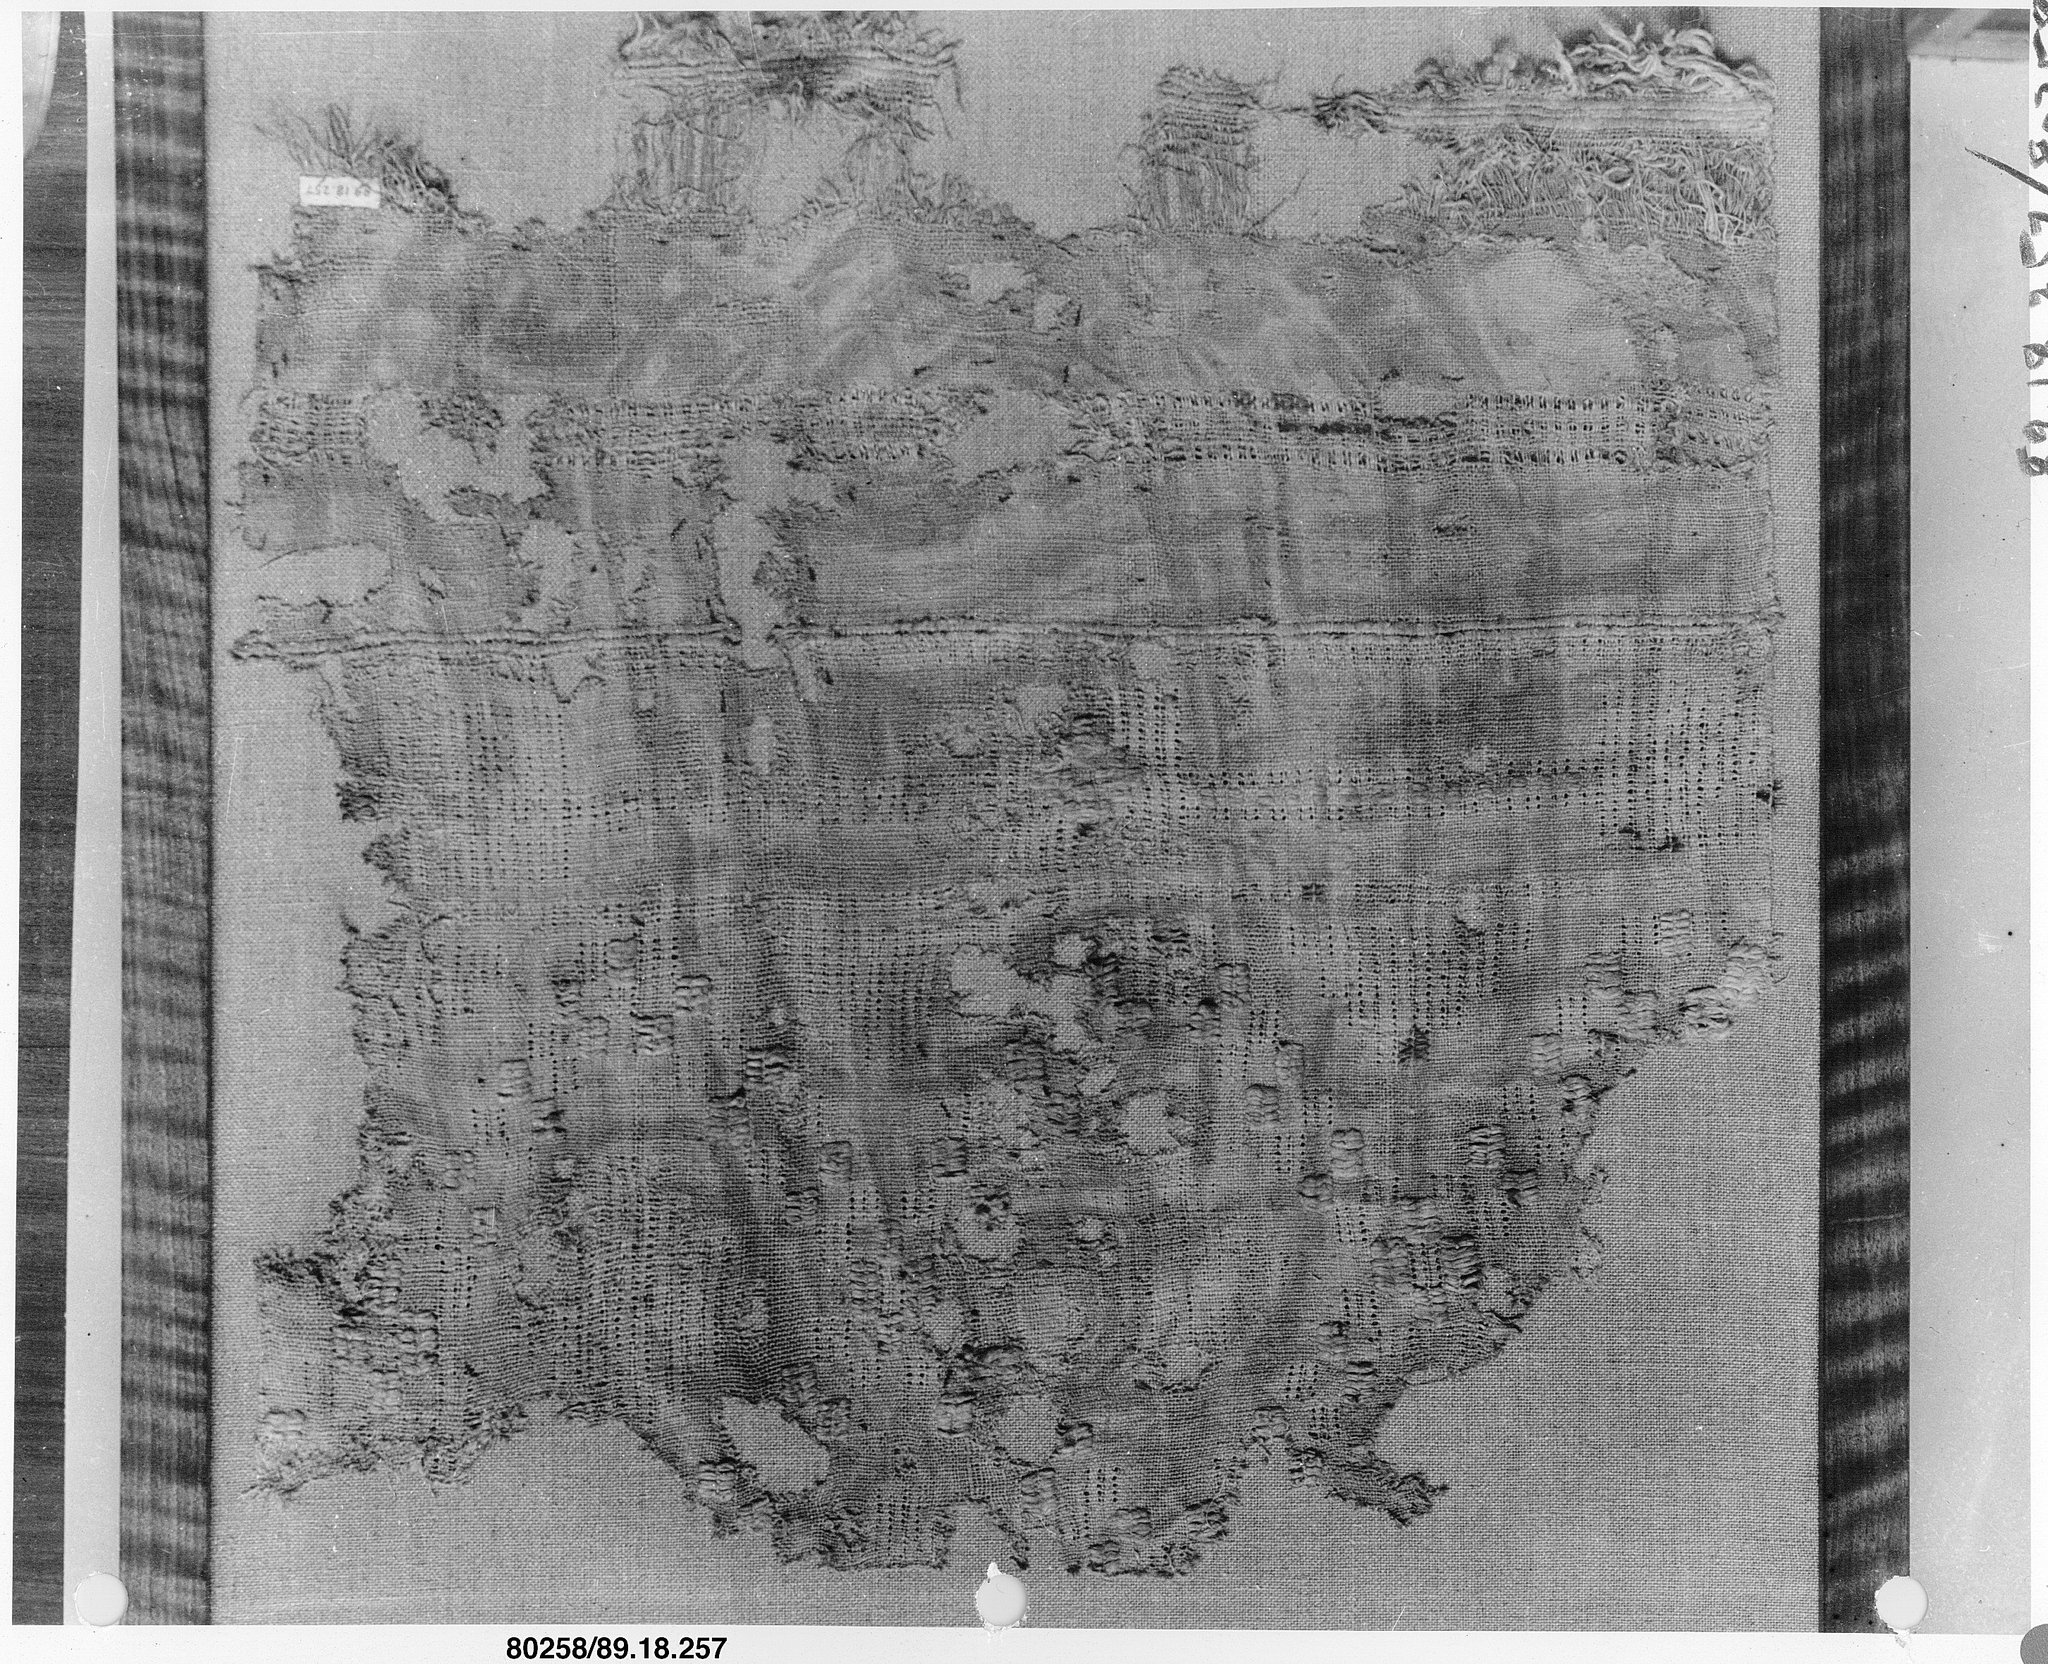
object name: textile fragment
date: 401-600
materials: linen, wool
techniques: weave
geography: egypt